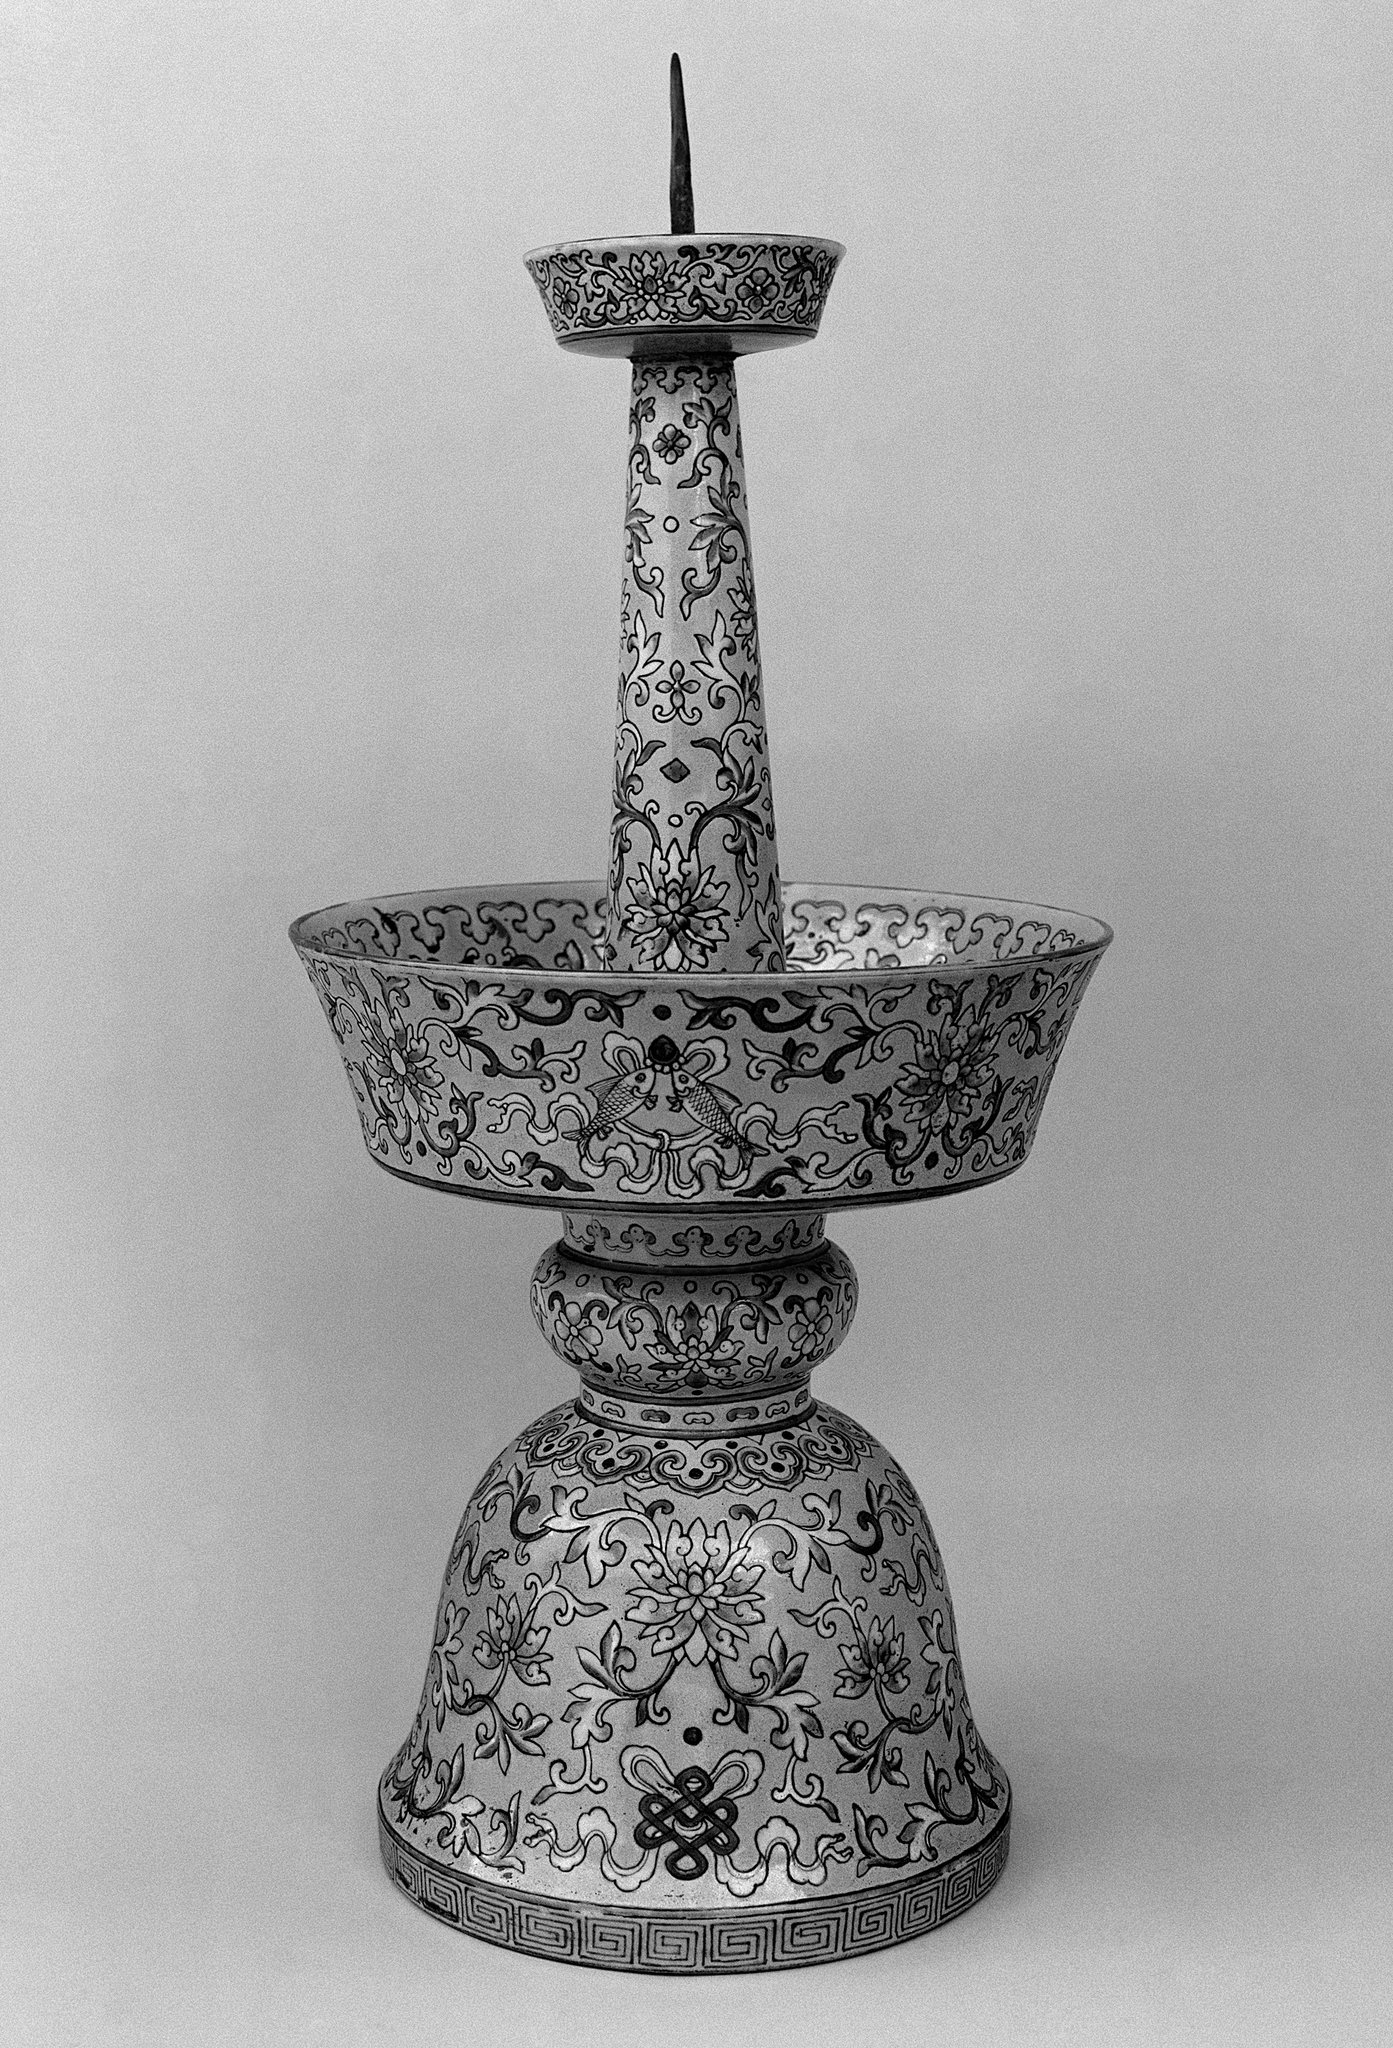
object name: altar set piece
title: Candlestick from a Set Five-Piece Altar Set (Wugong)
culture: chinese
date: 1821-1850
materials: porcelain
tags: fish,flowers